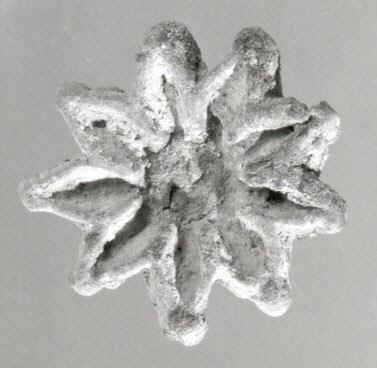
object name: stamp seal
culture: bactria-margiana archaeological complex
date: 2333-1668 BCE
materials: copper alloy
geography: bactria-margiana